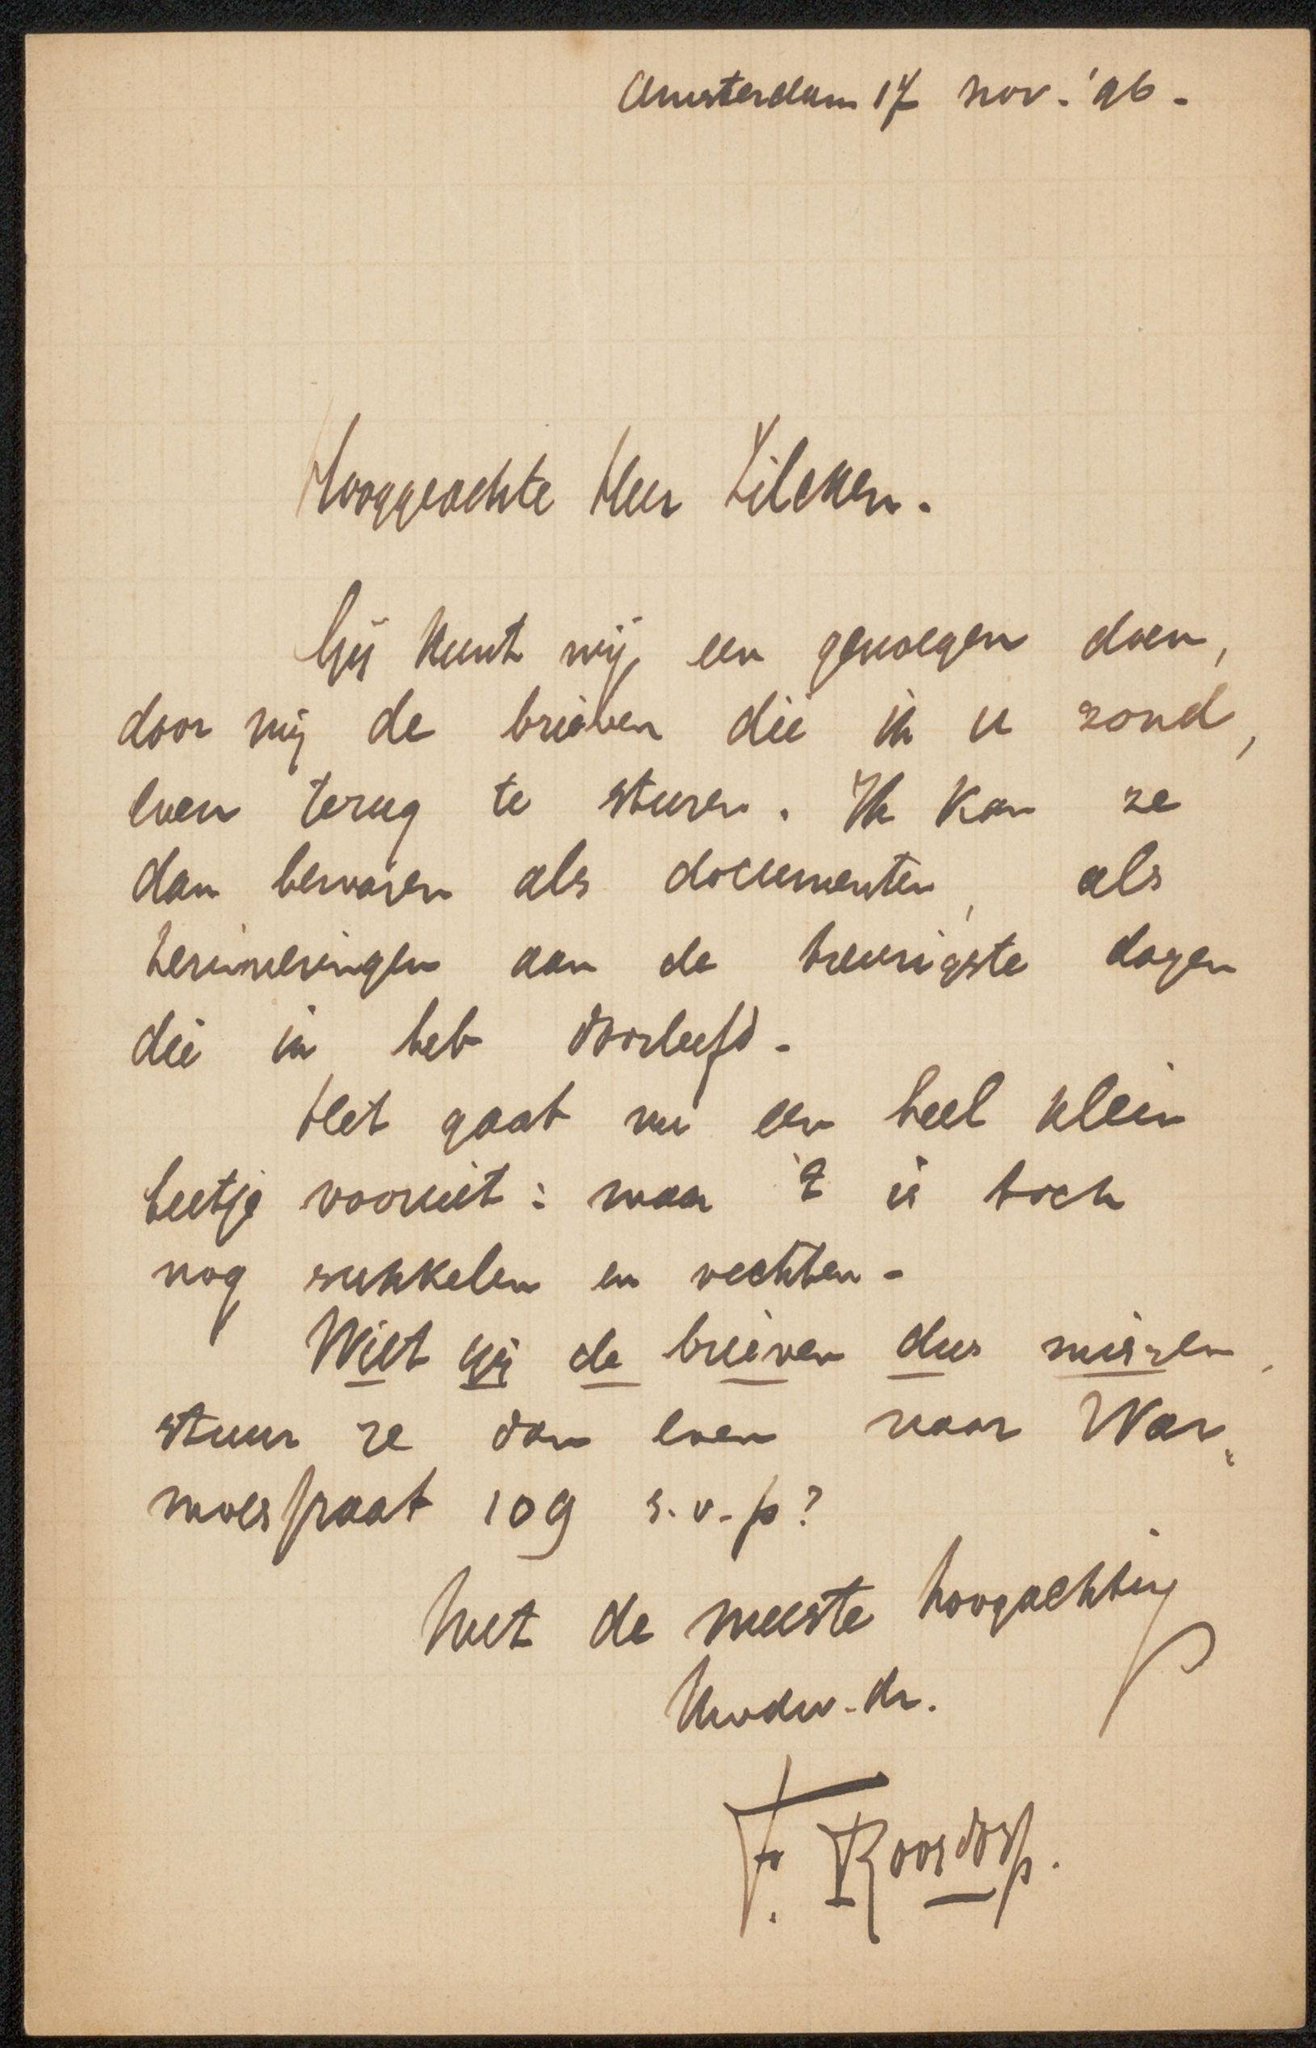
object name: letter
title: Brief aan Philip Zilcken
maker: frits roosdorp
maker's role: schrijver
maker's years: 1874-1898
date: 1896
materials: ink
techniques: pen, writing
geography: amsterdam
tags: the hague, painter, draughtsman, philip zilcken, passions, emotions, affections, diseases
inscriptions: collector's mark: ‘RPK’